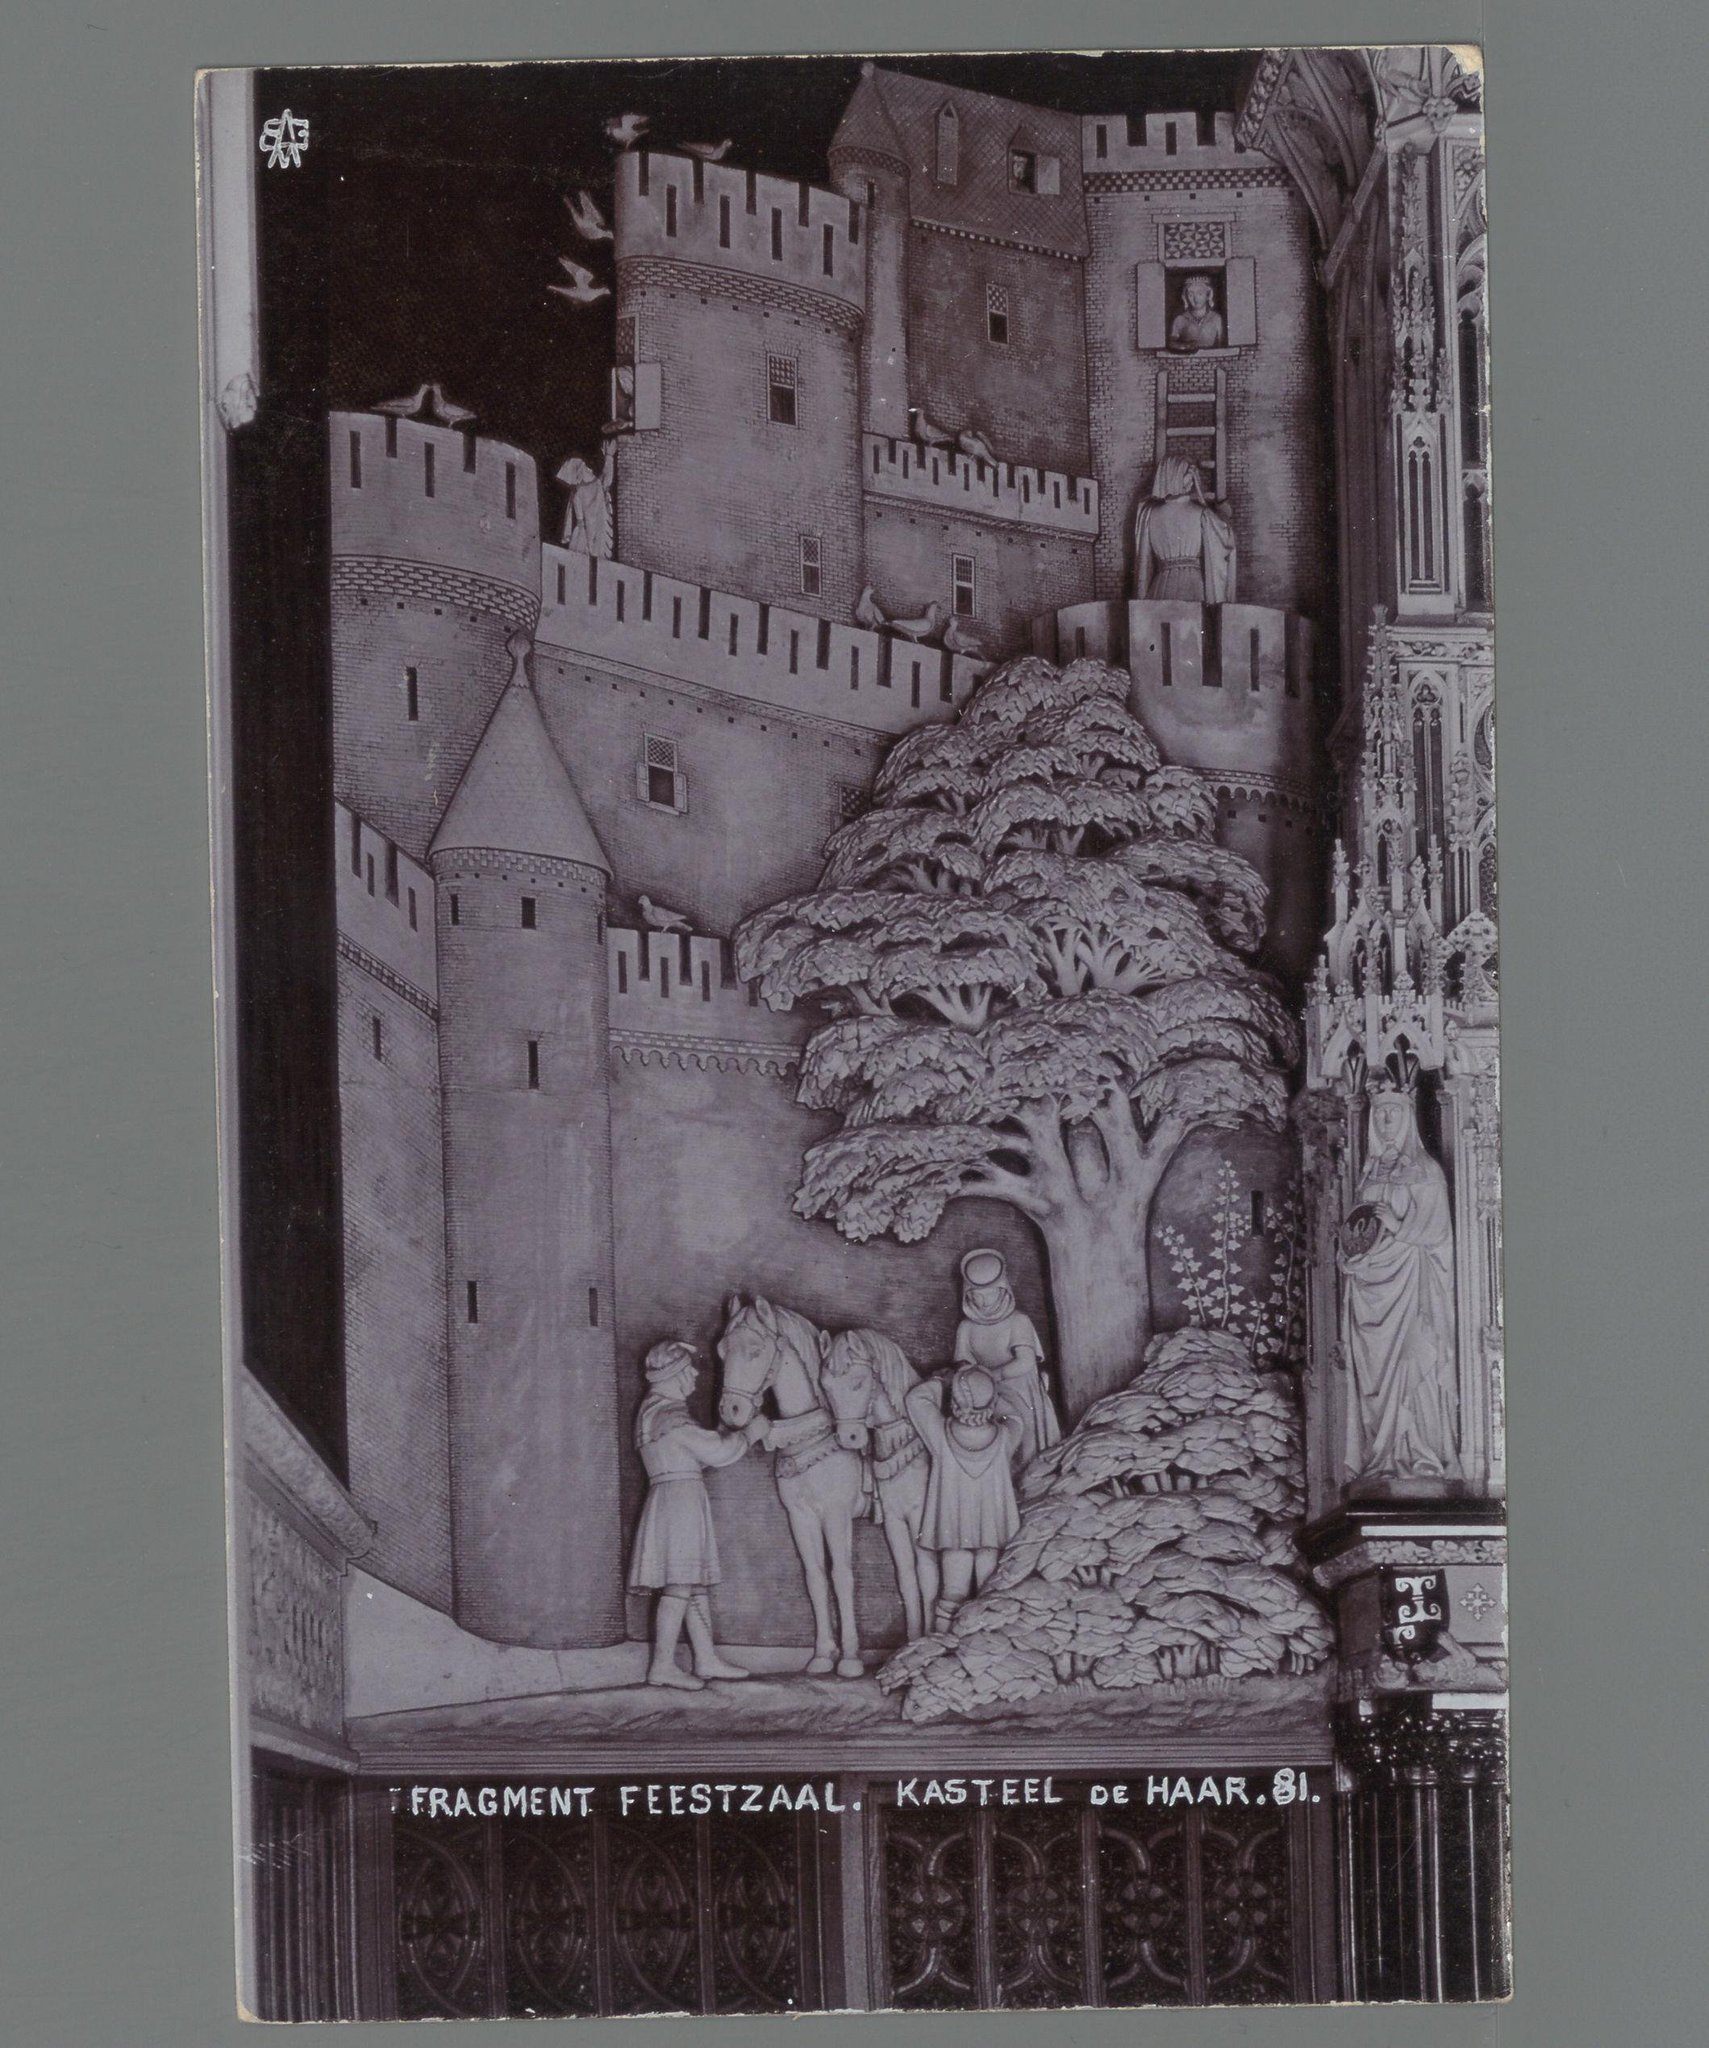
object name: photograph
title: Fragment feestzaal. Kasteel de Haar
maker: Anonymous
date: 1900-1930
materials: paper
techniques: collodion silver print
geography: haarzuilens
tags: castle, interior of the house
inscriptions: monogram: ‘EBvA’, monogram: ‘M.R.A. U.’